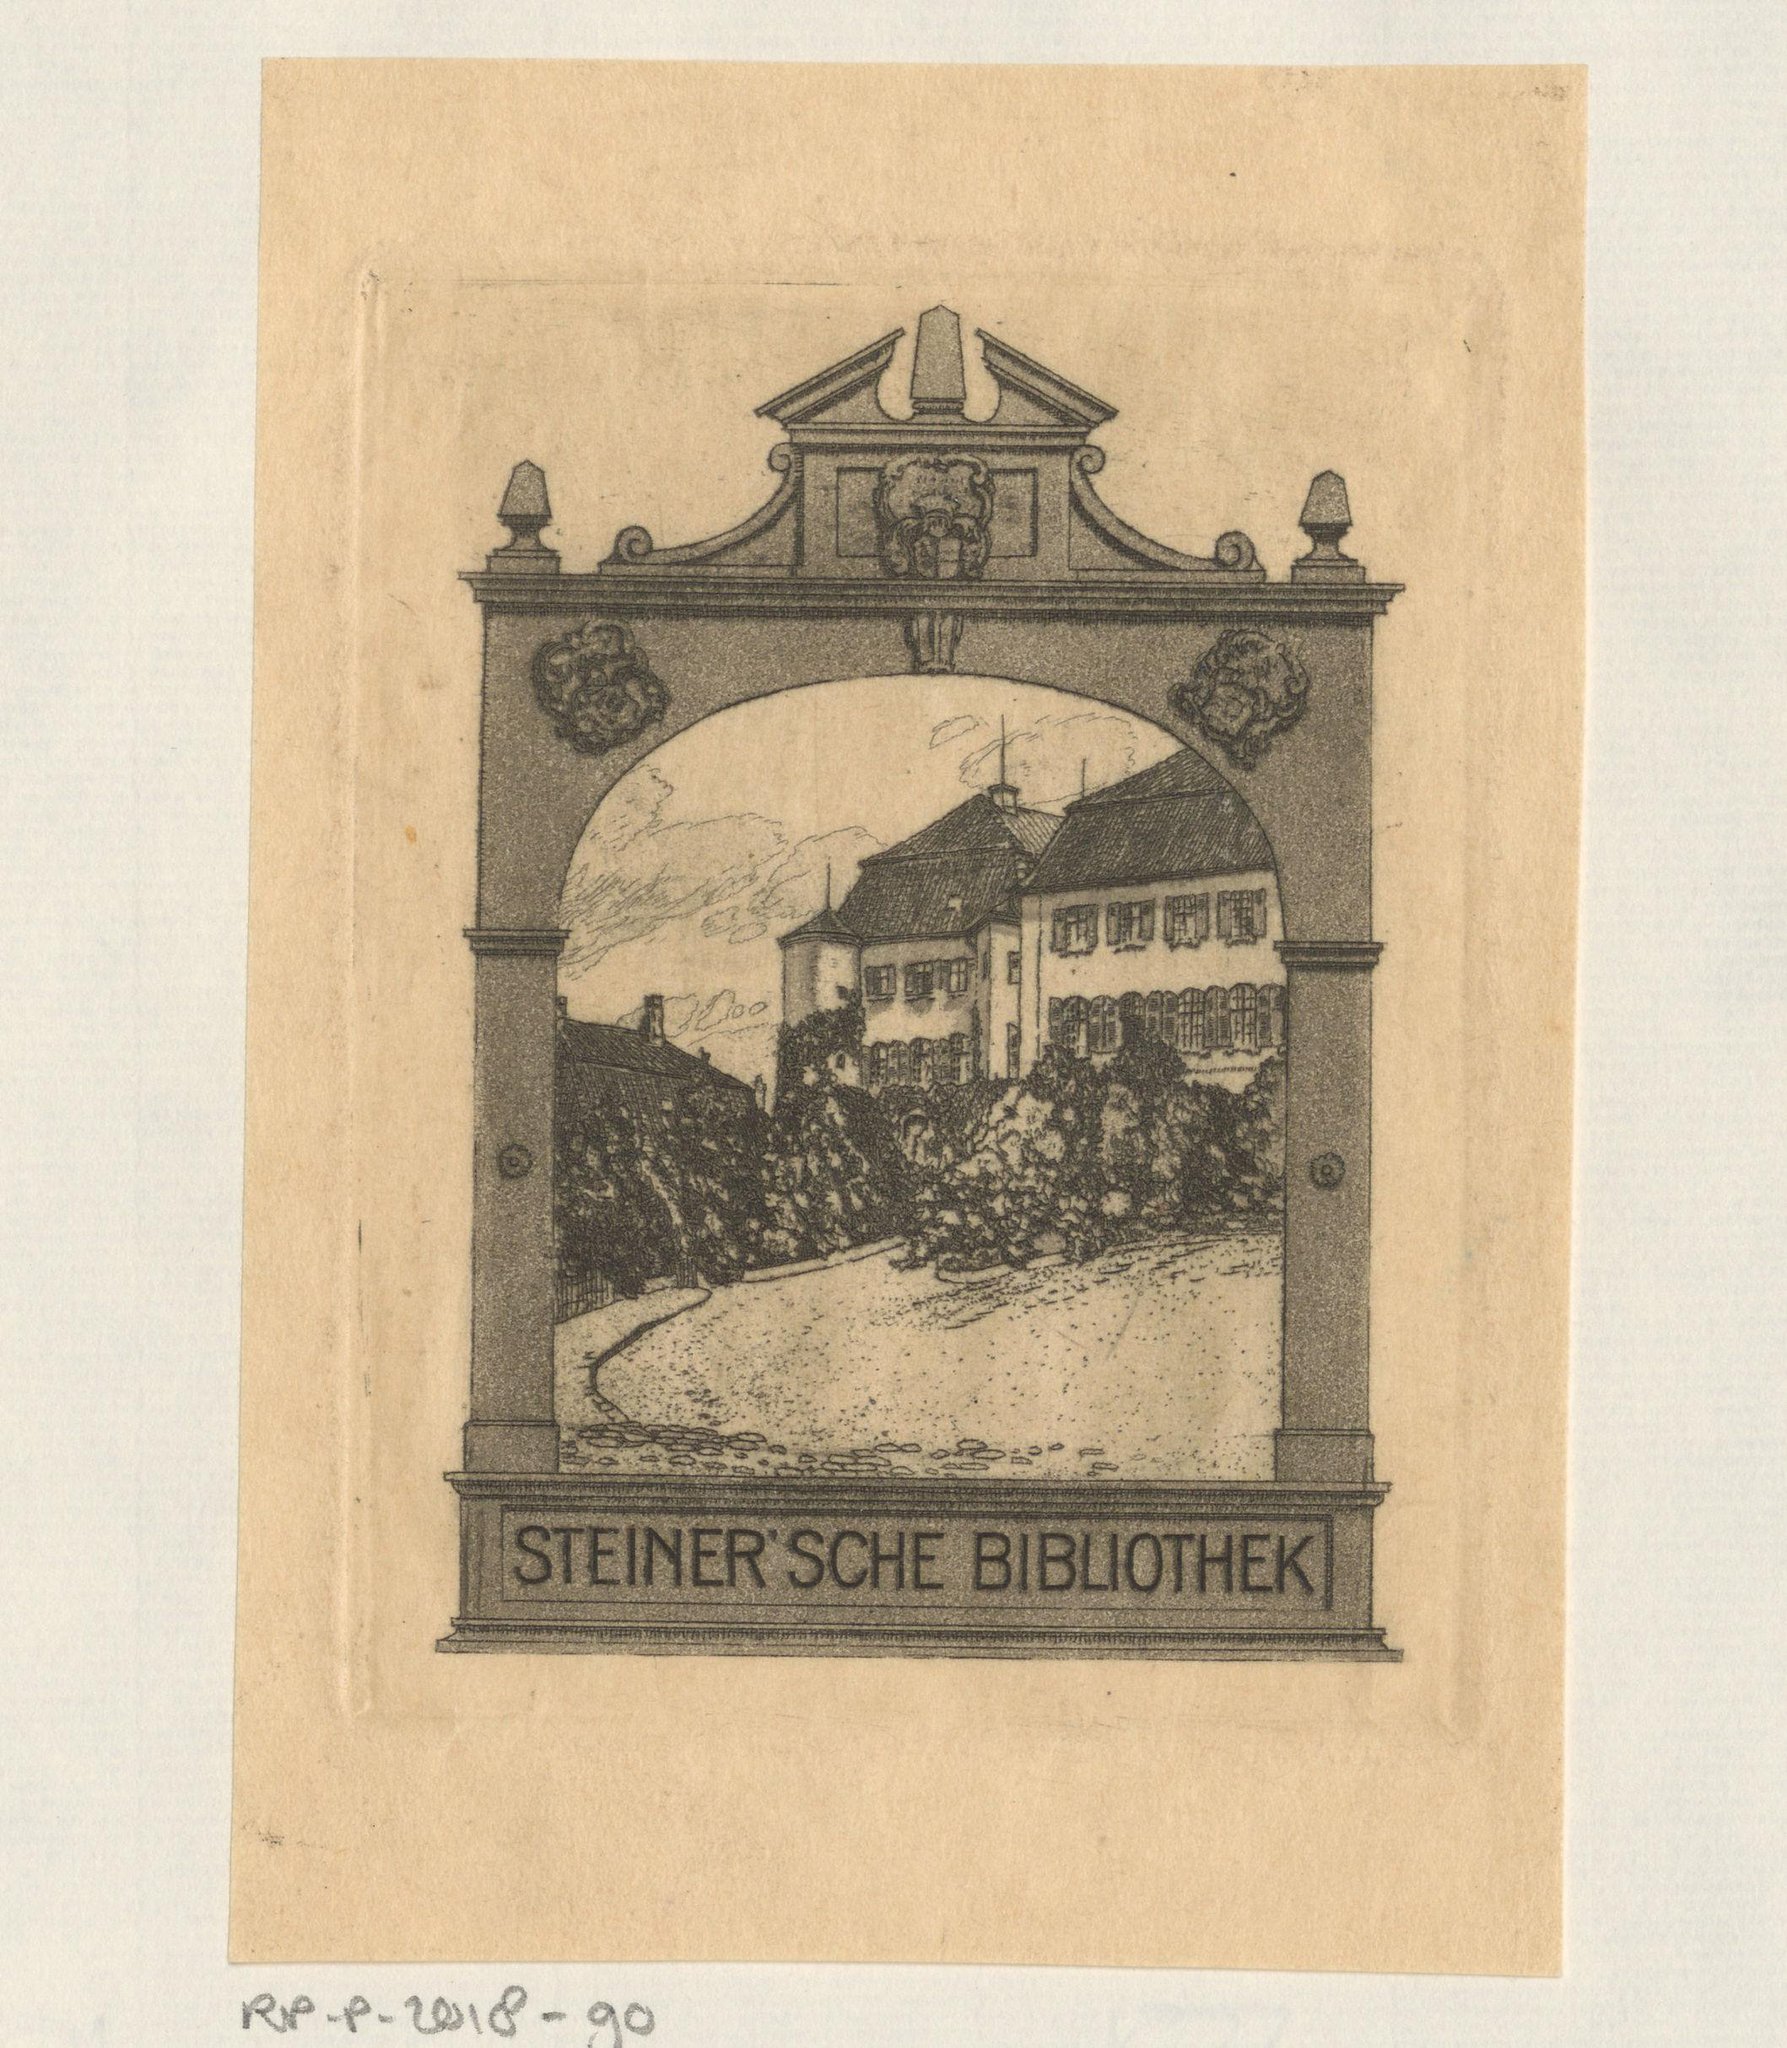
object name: bookplate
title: Ex libris van Steiner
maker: Anonymous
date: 1870-1949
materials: paper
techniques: aquatint, drypoint, etching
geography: germany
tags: arch, archivolt ~ architecture, housing